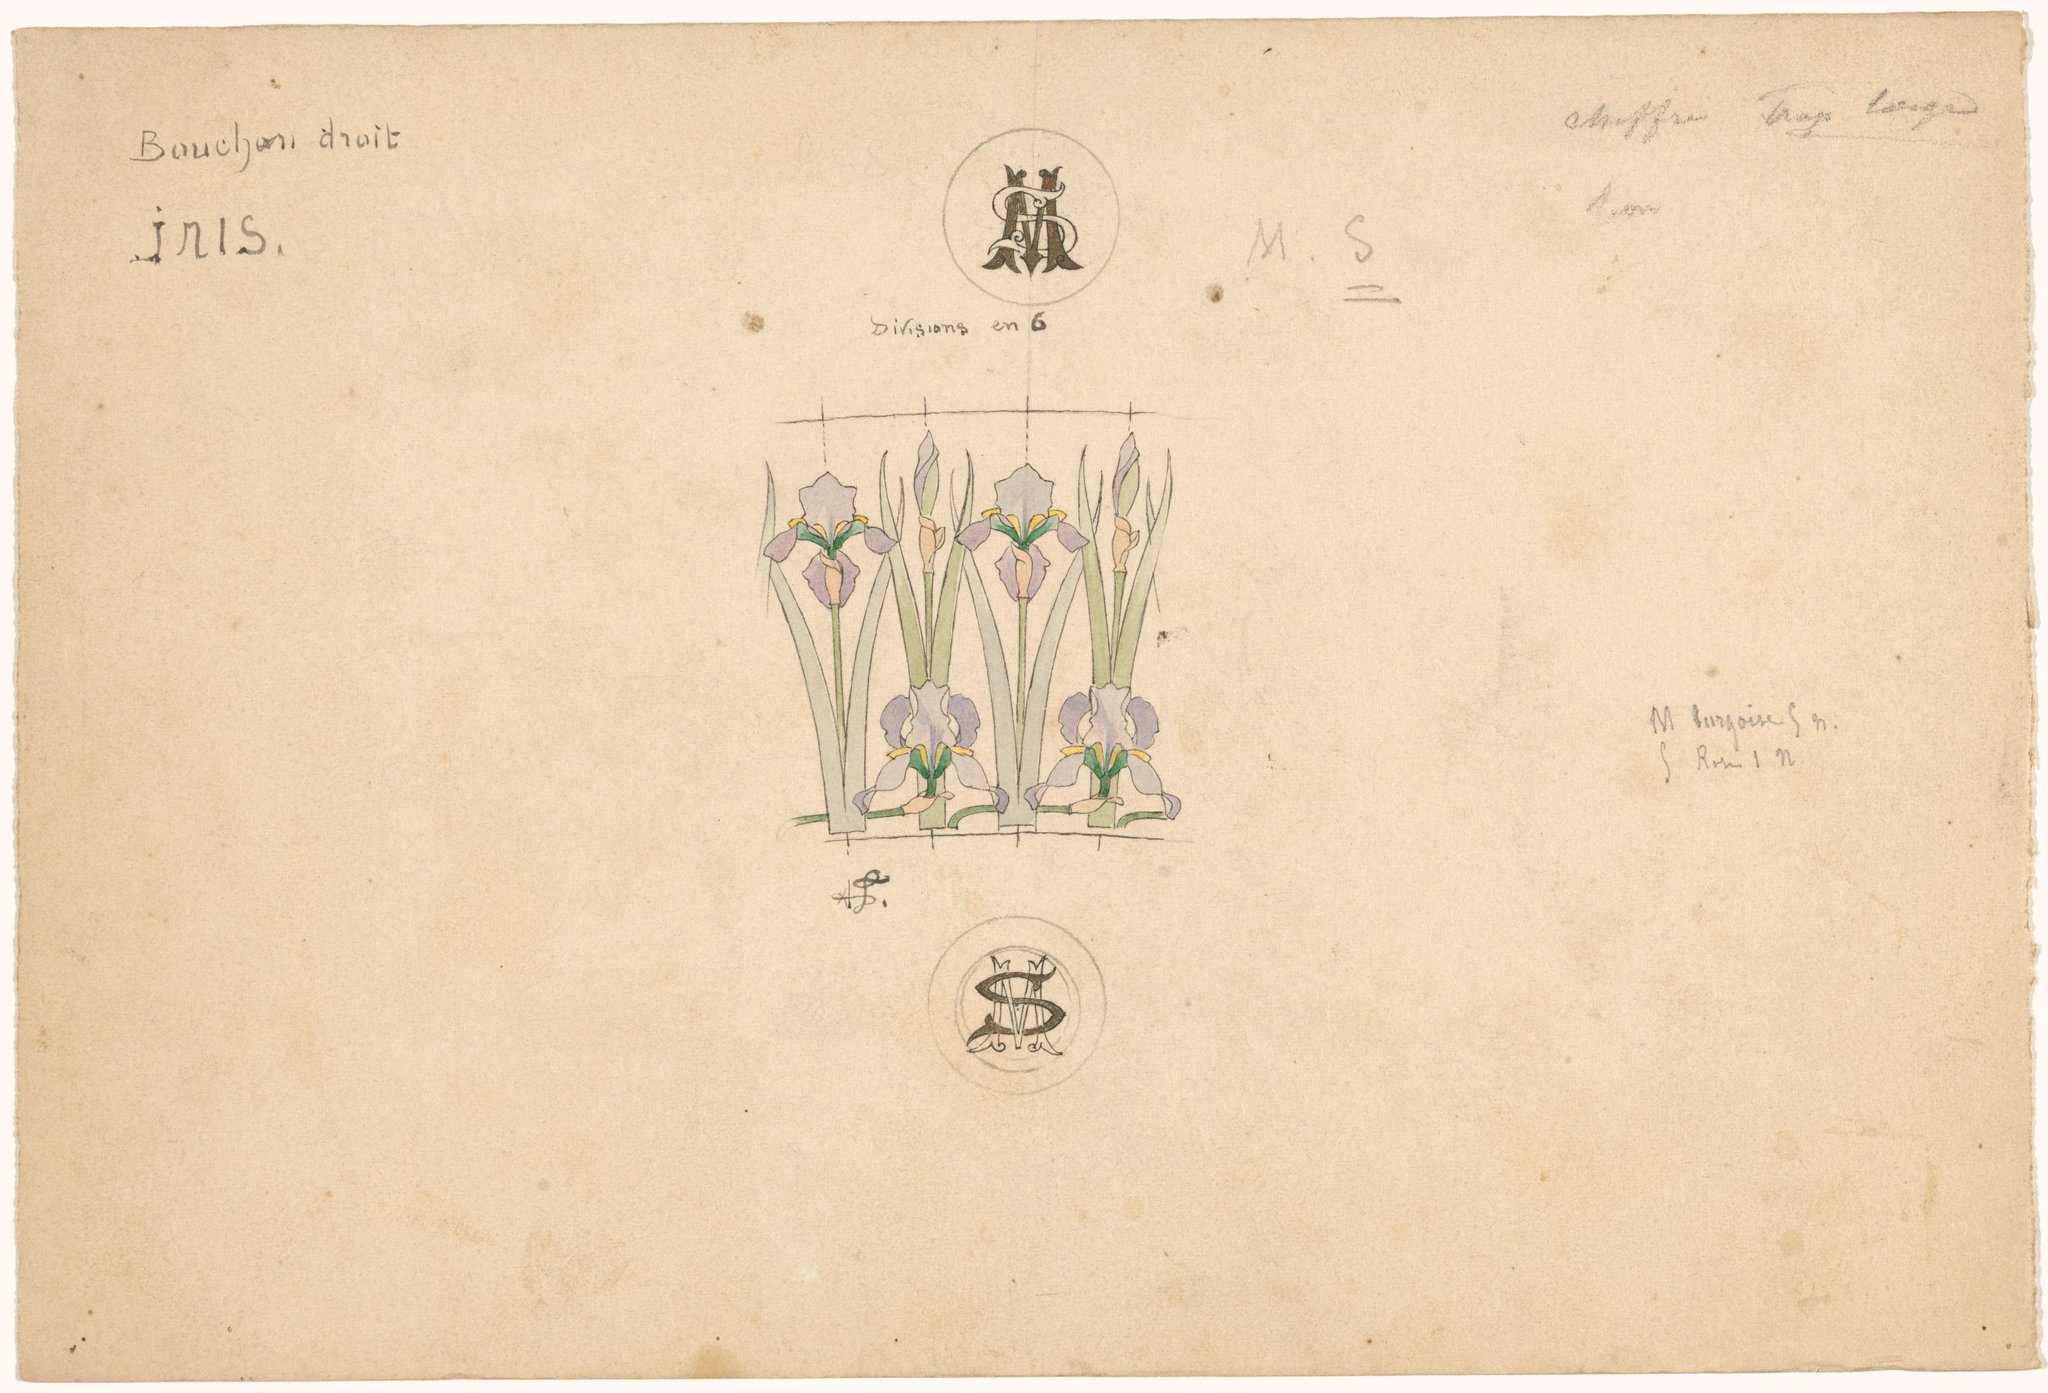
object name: design drawing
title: Vijf segmenten van een met irissen beschilderde knop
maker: anatole-alexis fournier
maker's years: 1864-1926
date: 1897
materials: graphite, ink, paper, watercolor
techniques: aquarelle, pen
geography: sèvres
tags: flowers: iris, flowers ~ ornament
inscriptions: inscription: ‘MS’, inscription: ‘Divisions en 6’, inscription: ‘Bouchon droit / iris’, signature: ‘AF’, inscription: ‘chiffre trop longue / Non; midden rechts: M turquoise s n. / S Rose s n.’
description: Daarboven en daaronder een rond medaillon met een monogram van de letters SM.